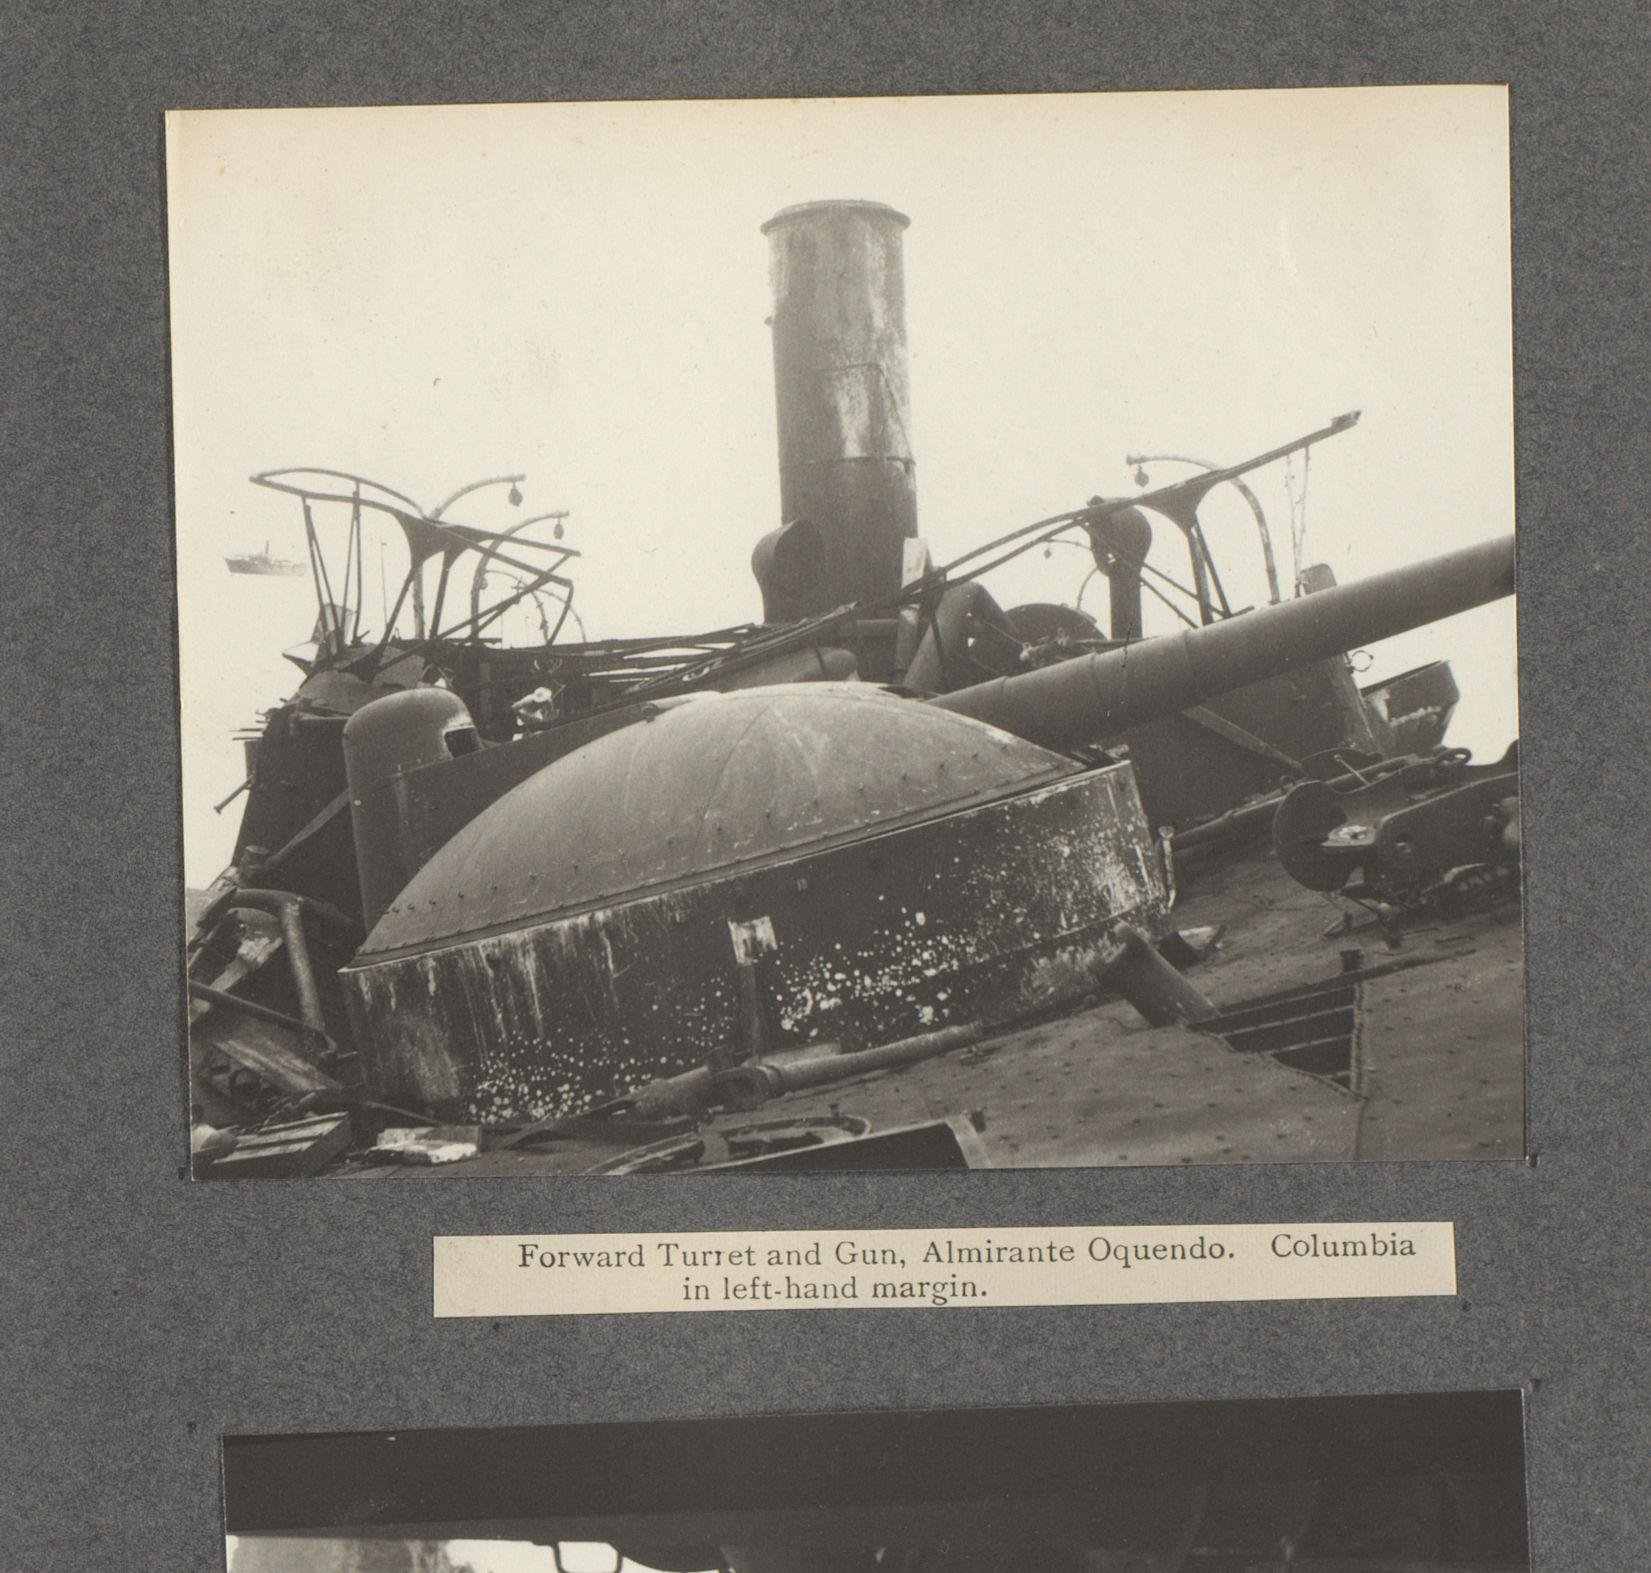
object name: photograph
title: Wrak van de Almirante Oquendo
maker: Anonymous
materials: paper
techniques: platinum process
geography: santiago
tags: shipwreck